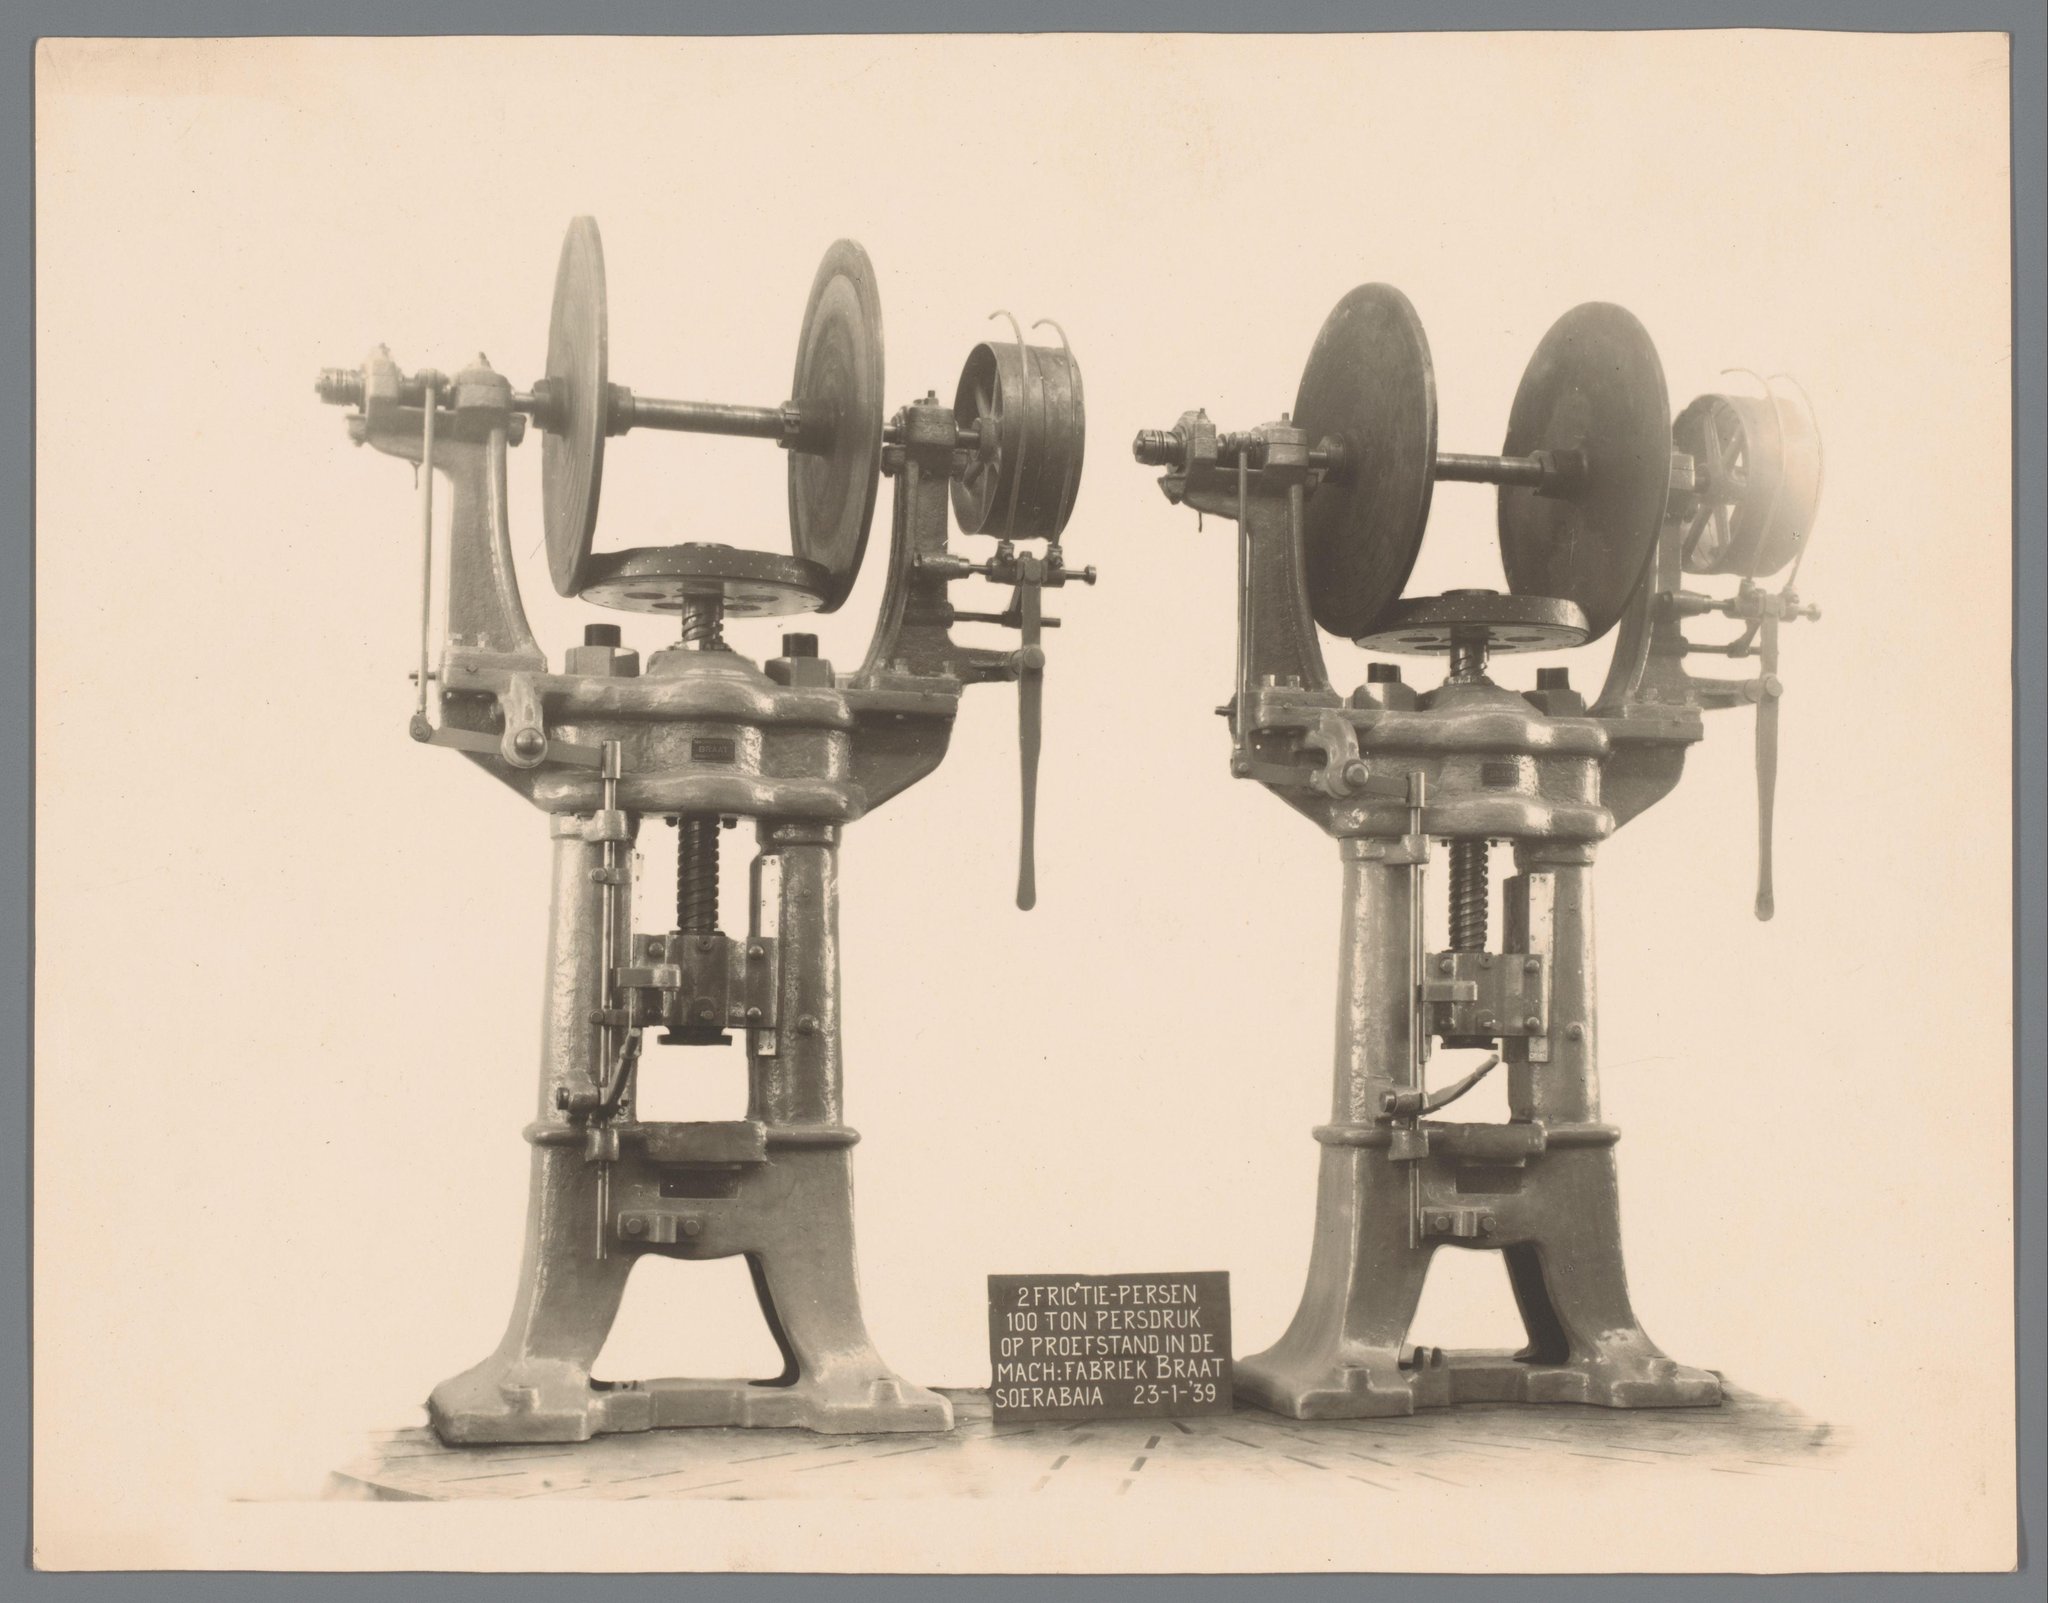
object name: photograph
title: Frictiepersen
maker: Anonymous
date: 1939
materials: photographic support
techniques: gelatin silver print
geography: surabaya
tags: colonial system, factory-interior, machine shop, machines; parts of machines; tools and appliances, java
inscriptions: date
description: Twee frictiepersen, vervaardigd in 1939. Onderdeel van de multomap met foto's van machines van de N.V. Machinefabriek Braat te Soerabaja, Soekaboemi en Jogyakarta, uit de periode 1908-1942.